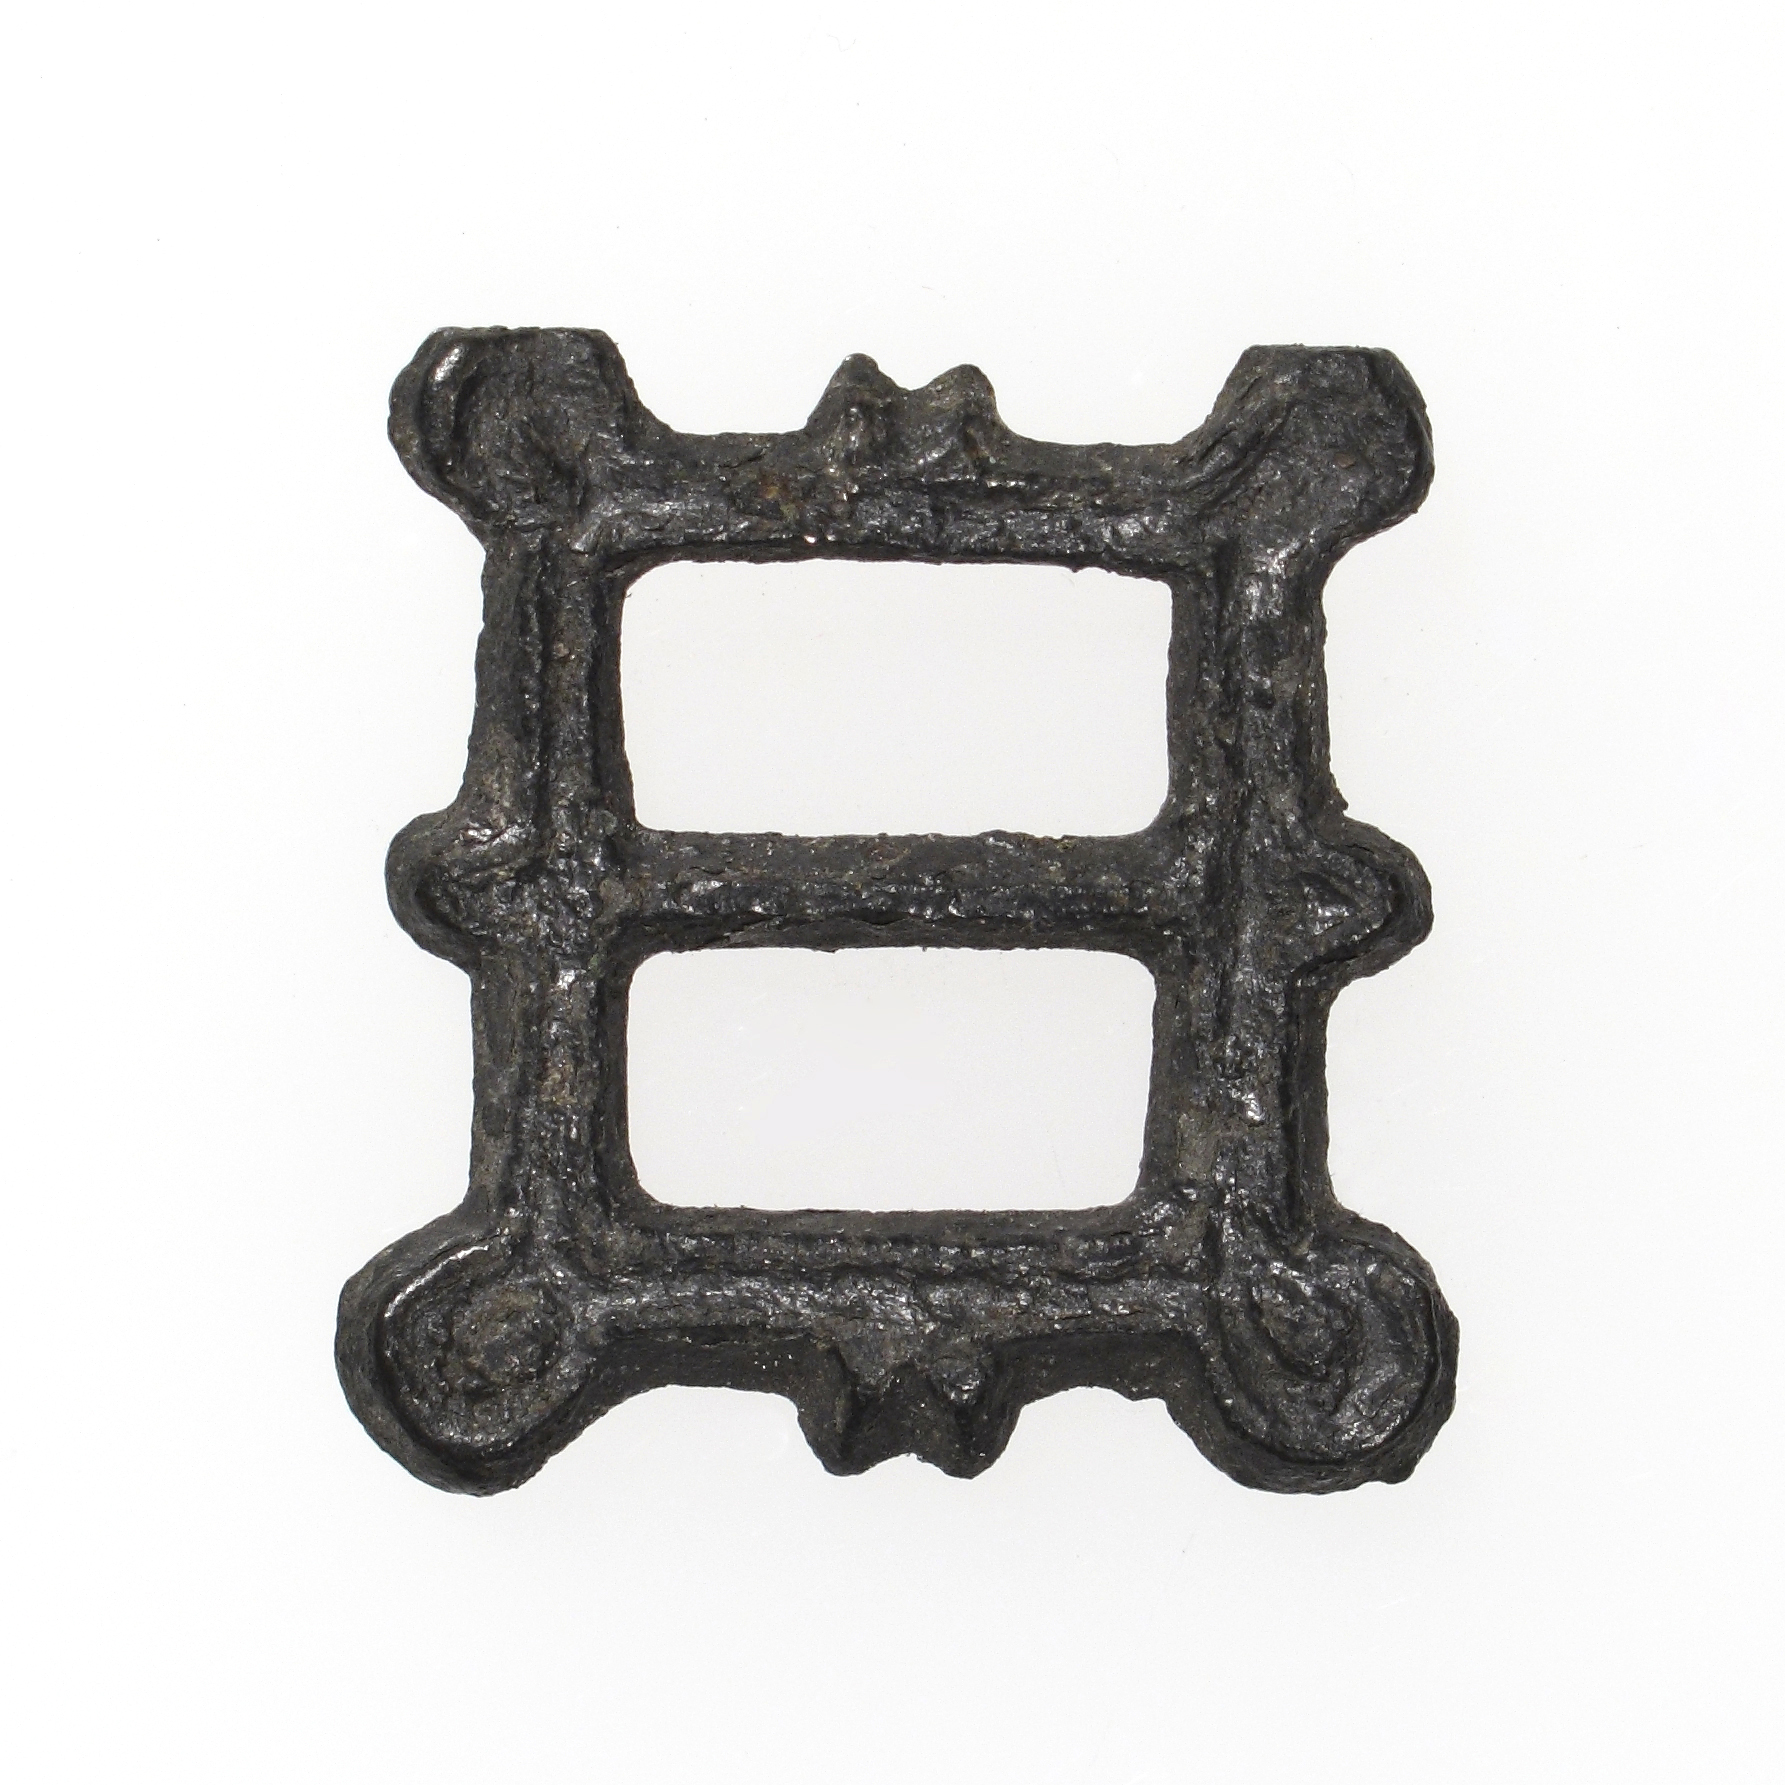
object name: pilgrim's badge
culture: french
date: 1301-1600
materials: lead